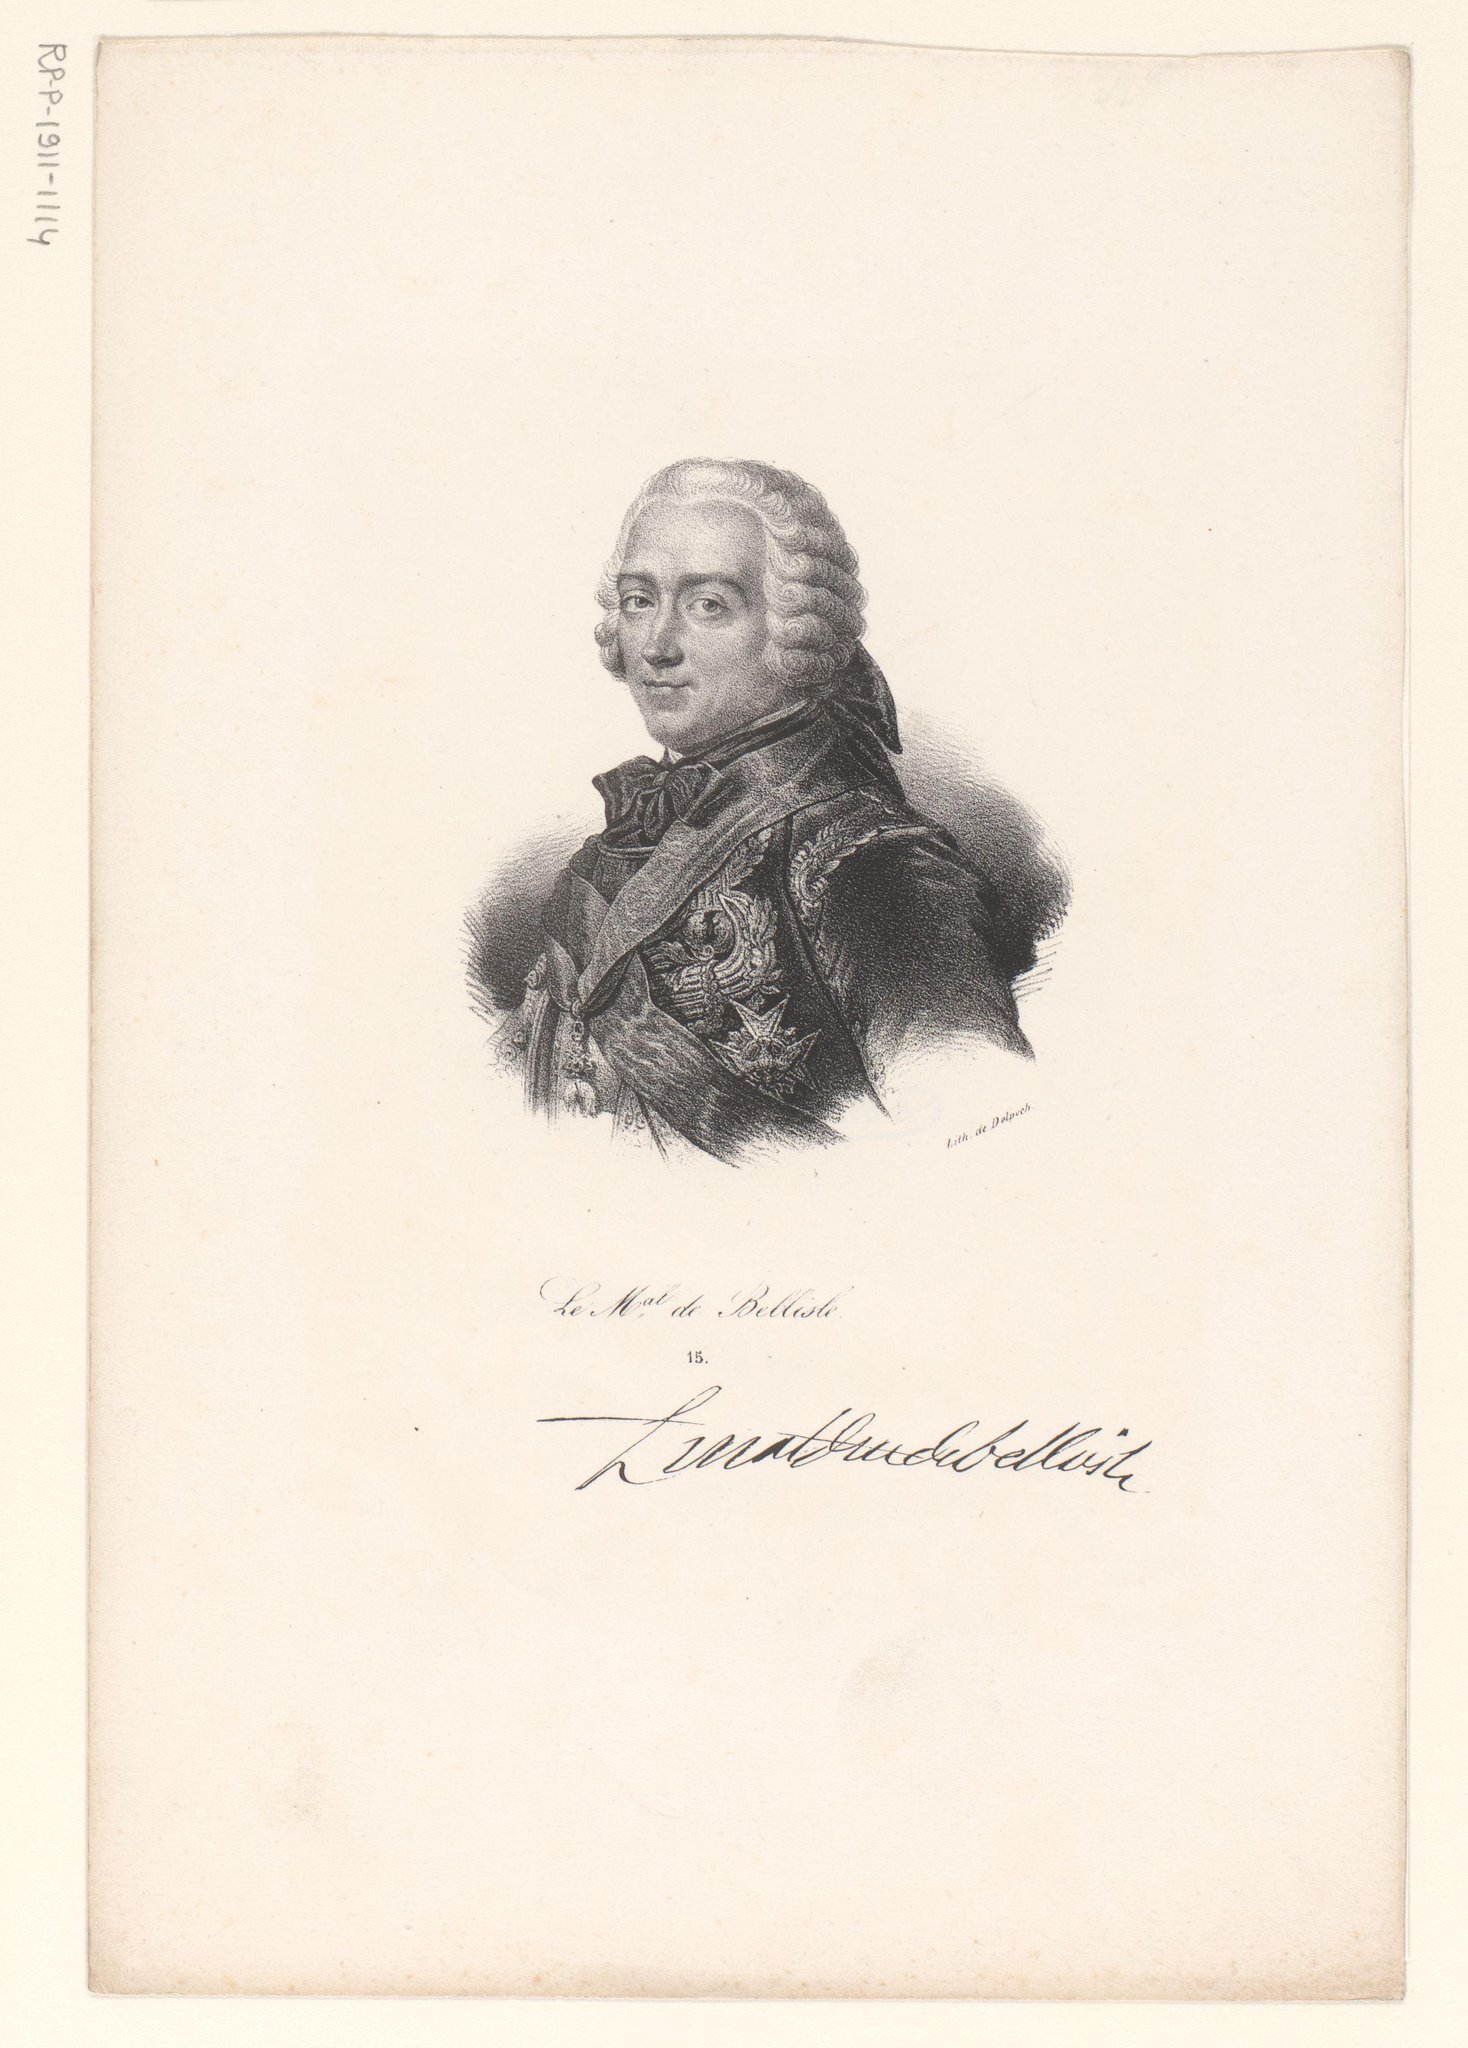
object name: print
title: Portret van Charles Louis Auguste Fouquet de Belle-Isle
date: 1818-1842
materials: paper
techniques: lithograph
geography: paris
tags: france, charles louis auguste fouquet (duc de belle-isle), historical persons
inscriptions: collector's mark: Lugt 2228a